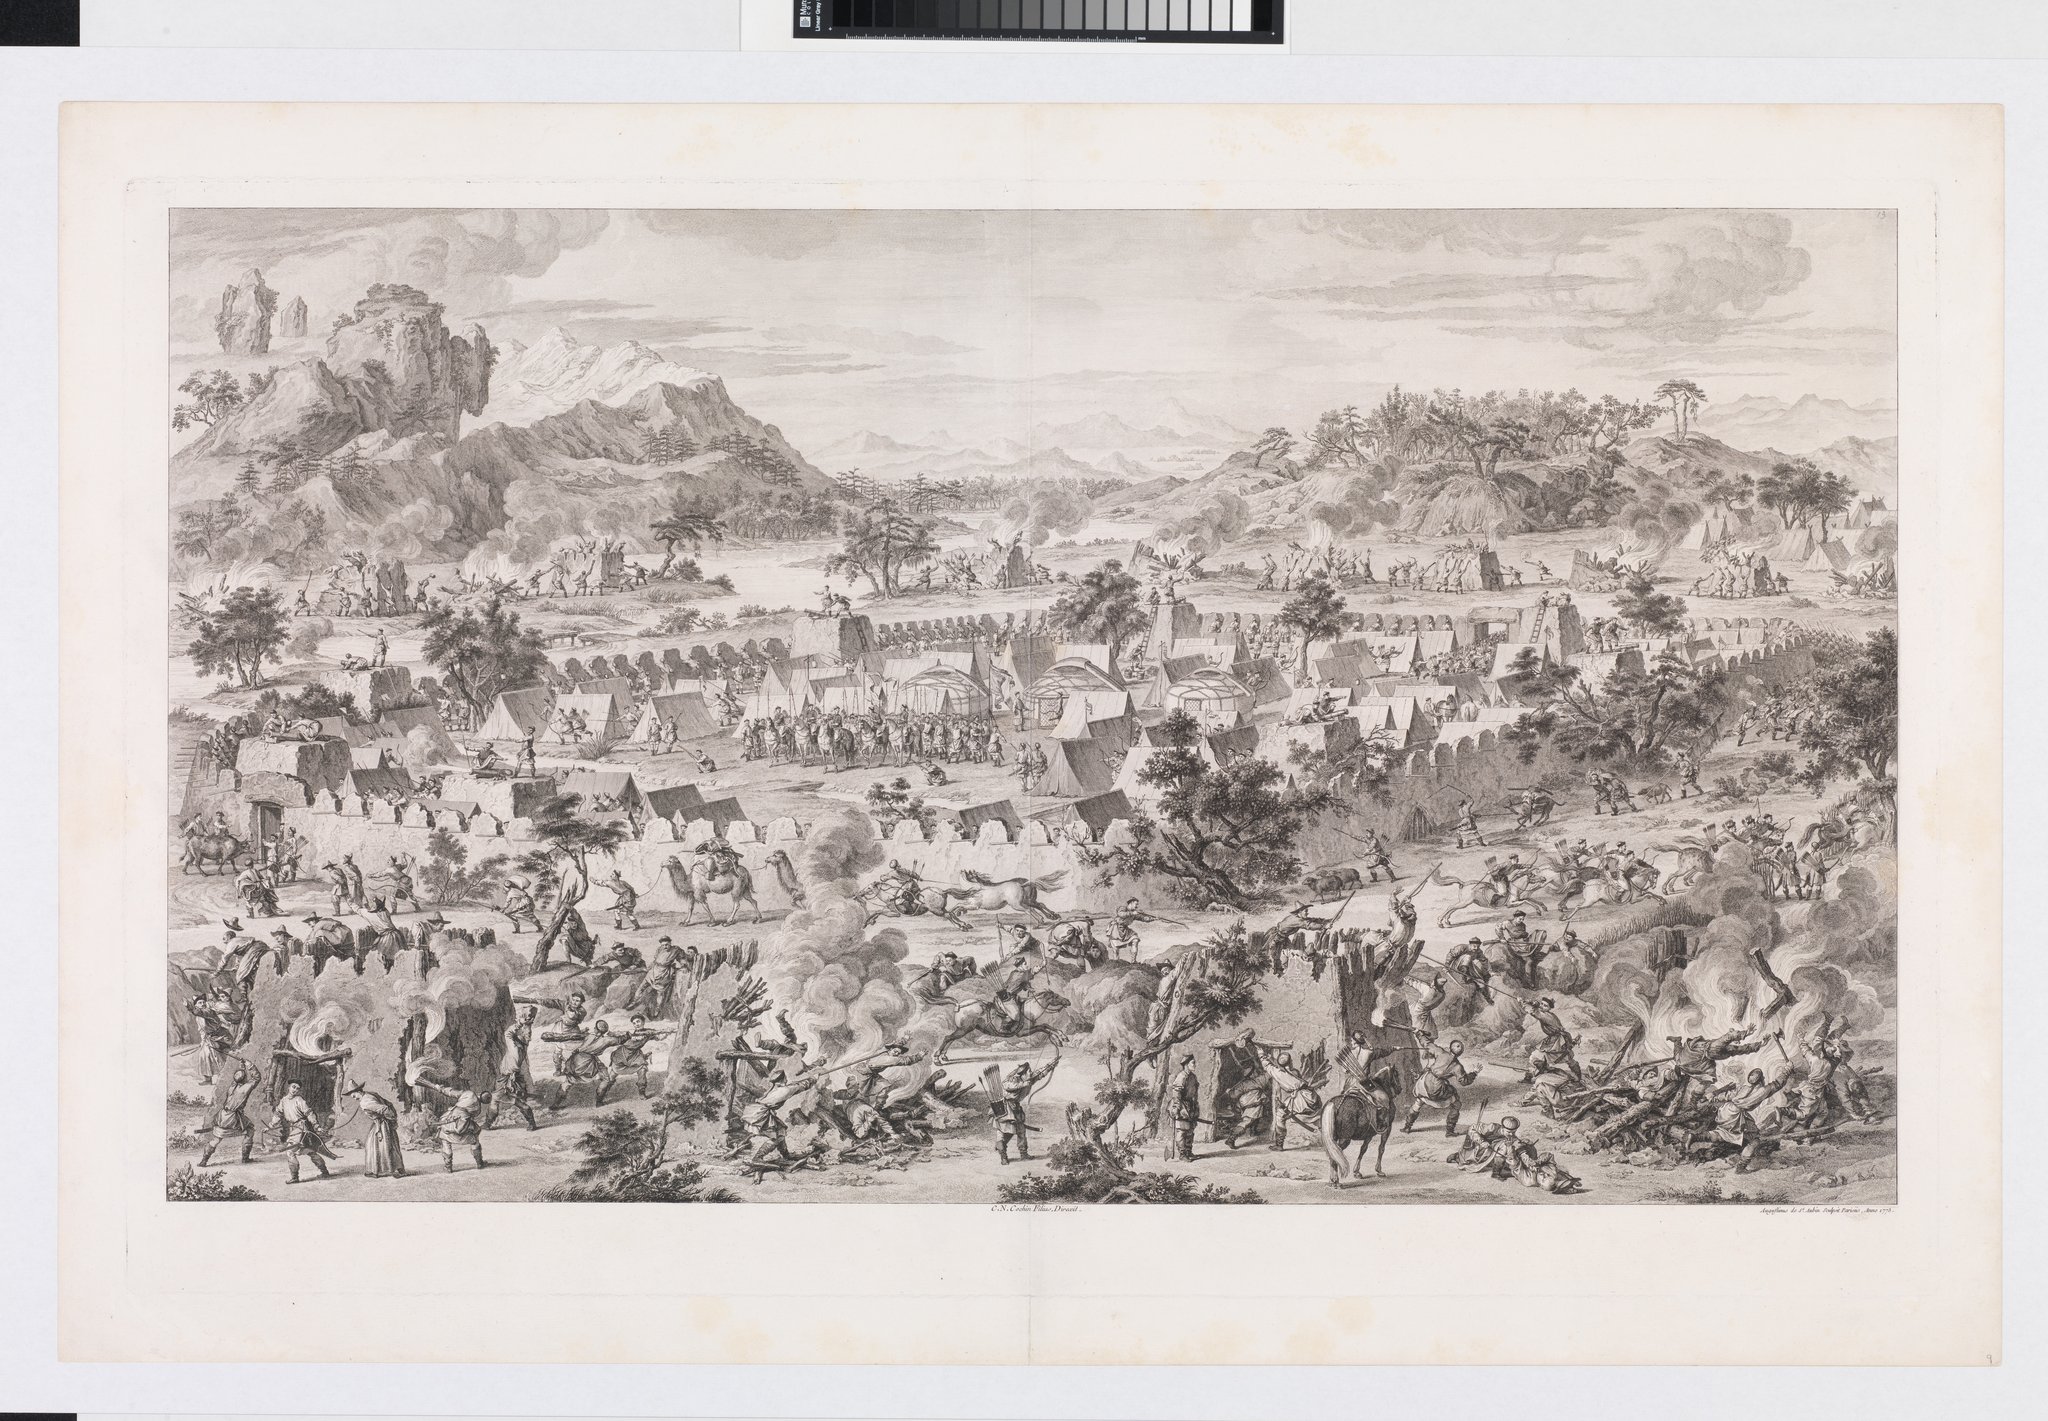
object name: print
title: The Battle of Tonguzluq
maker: augustin de saint-aubin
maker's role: artist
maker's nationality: french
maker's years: 1736-1807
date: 1773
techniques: engraving, etching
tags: battles,soldiers,massacres,horses